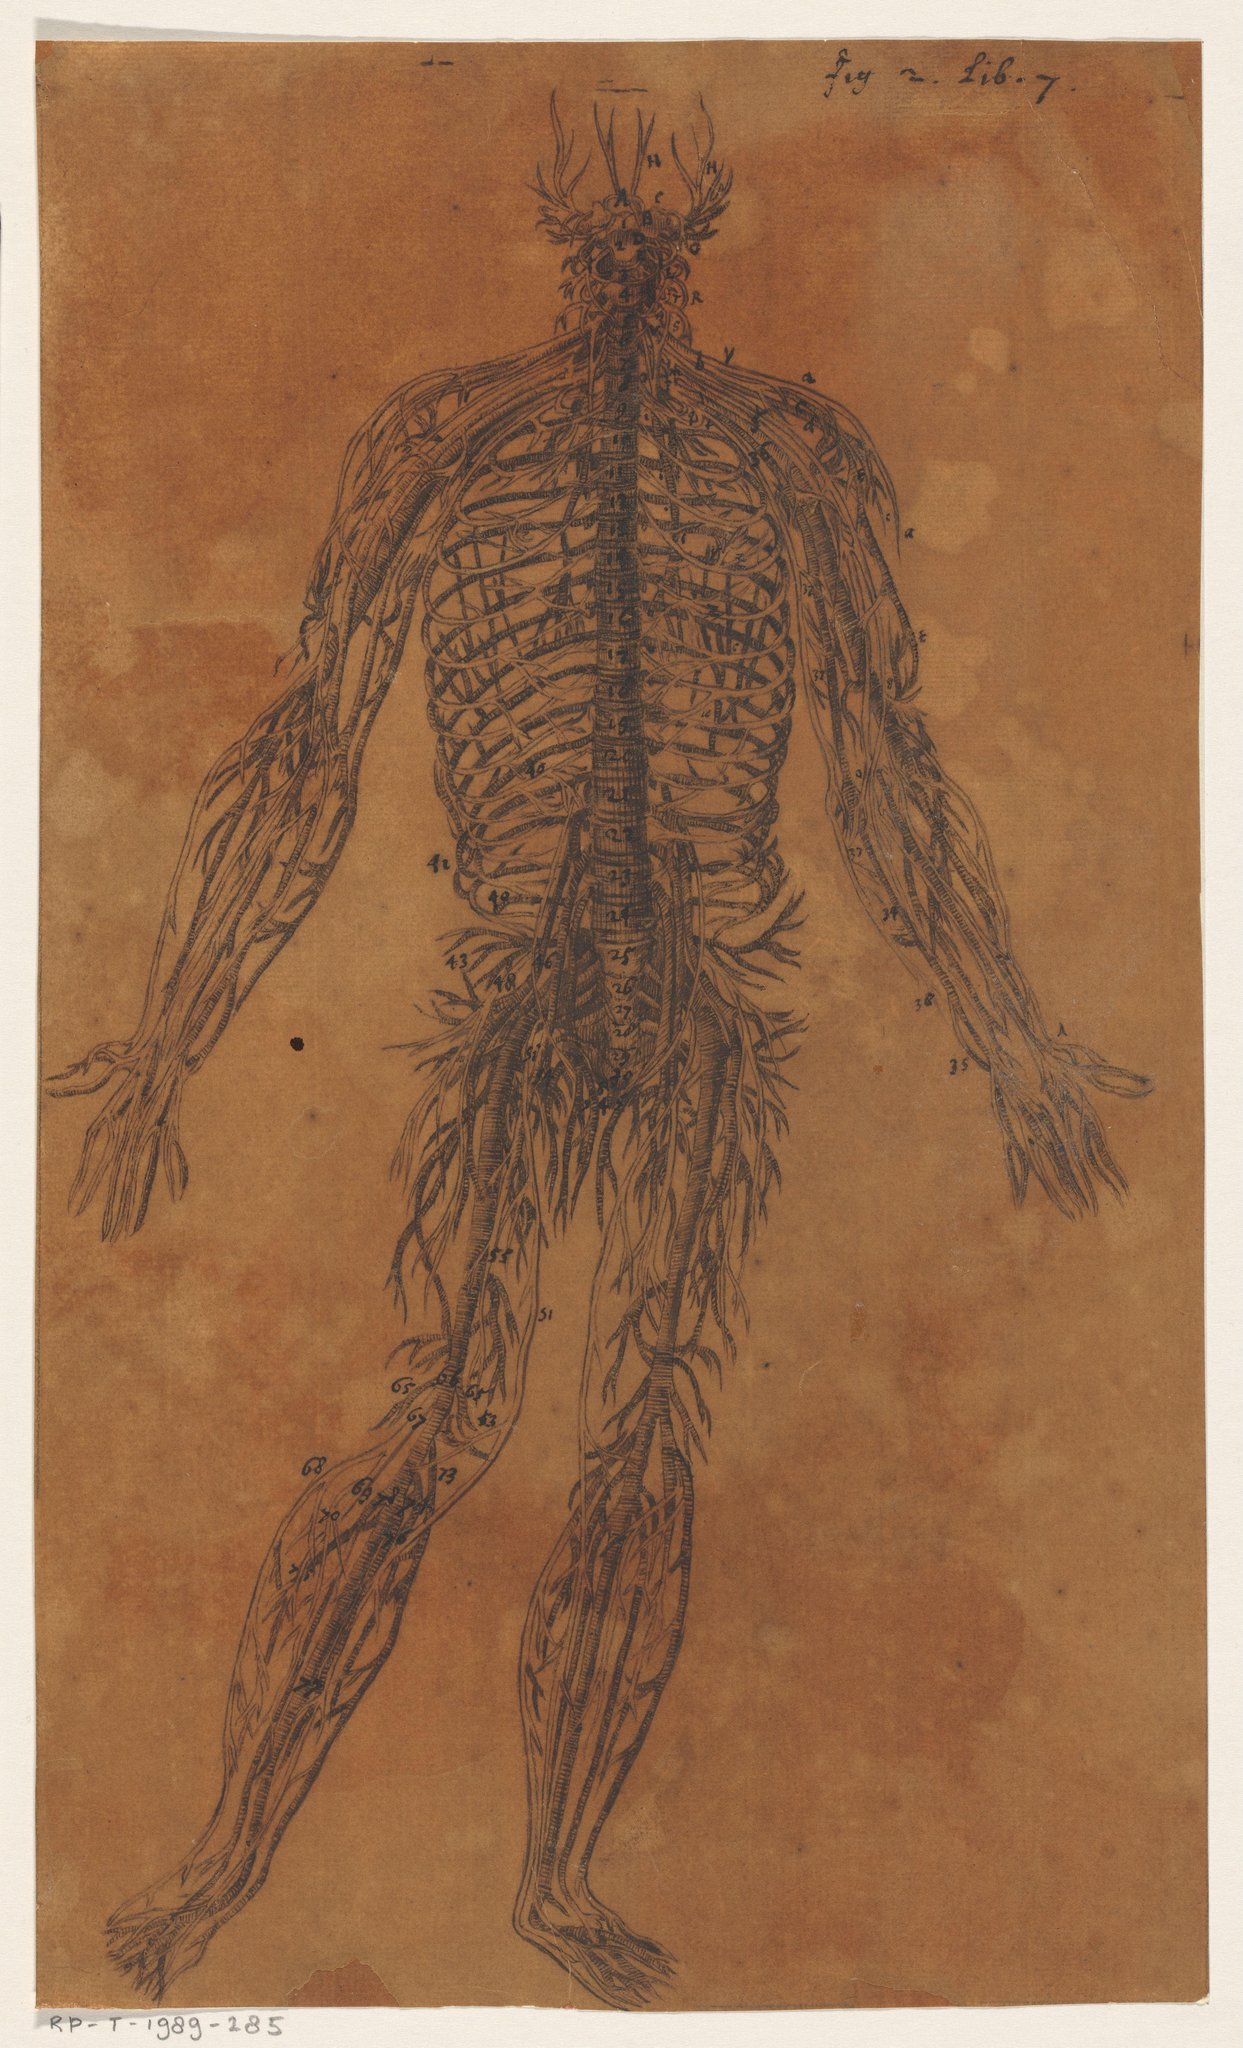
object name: drawing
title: Anatomische studie van de ruggenwervel en zenuwen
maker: Anonymous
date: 1630-1649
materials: ink, paper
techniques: pen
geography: low countries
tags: spine, anatomical model of the nerves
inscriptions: collector's mark: Lugt 2228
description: De tekening en de letters die de verschillende onderdelen aanduiden komen overeen met een prent uit: Spiegel, Adriaan van den, en Daniel Bucretius. De humani corporis fabrica libri decem. Venetië: s.n., 1627. Tekening zit in een omslag met meerdere anatomische tekeningen, genummerd RP-T-1989-256 en RP-T-1989-258 t/m RP-T-1989-289.